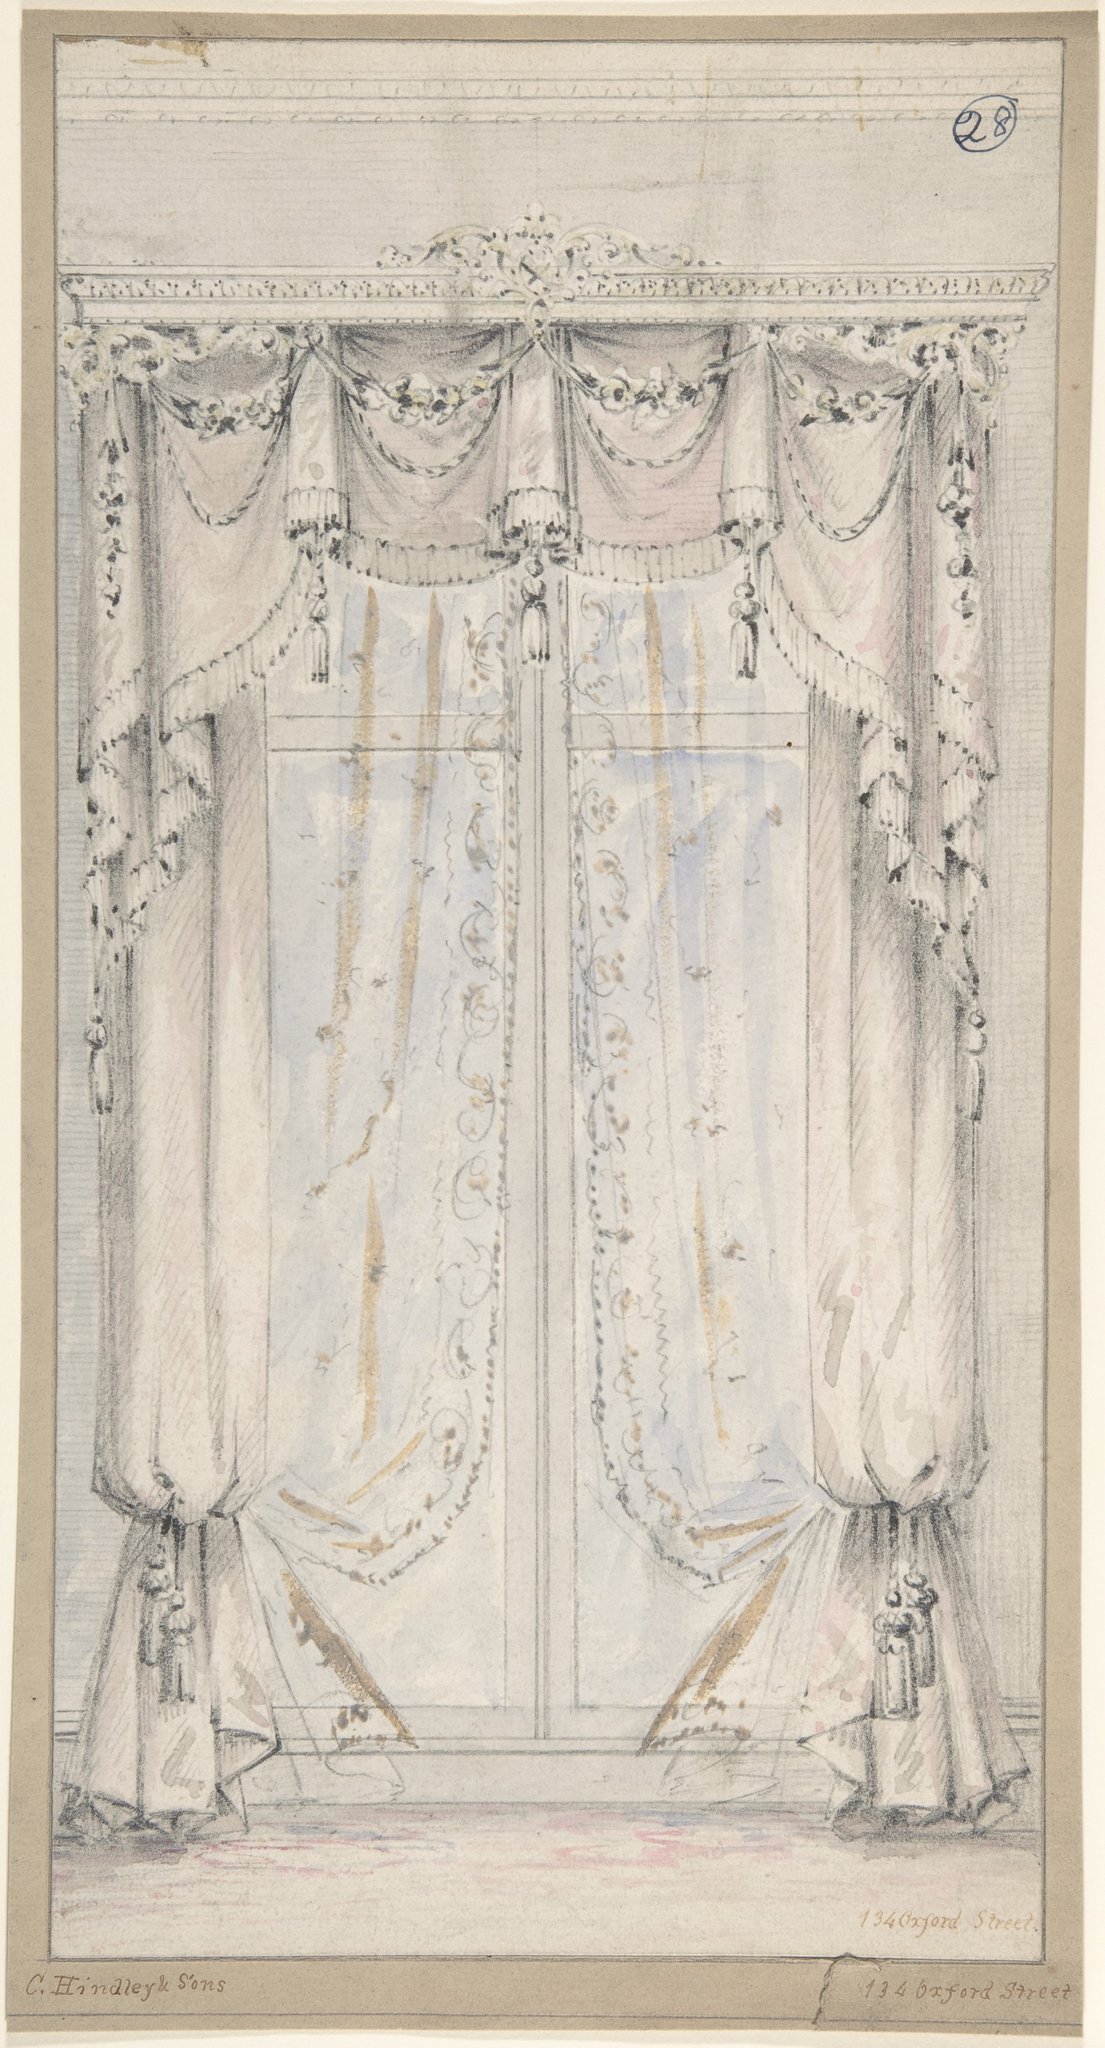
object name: drawing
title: Design for Curtains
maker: charles hindley and sons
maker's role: artist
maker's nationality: british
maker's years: 1841-1917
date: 1841-1884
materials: graphite, watercolor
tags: curtains